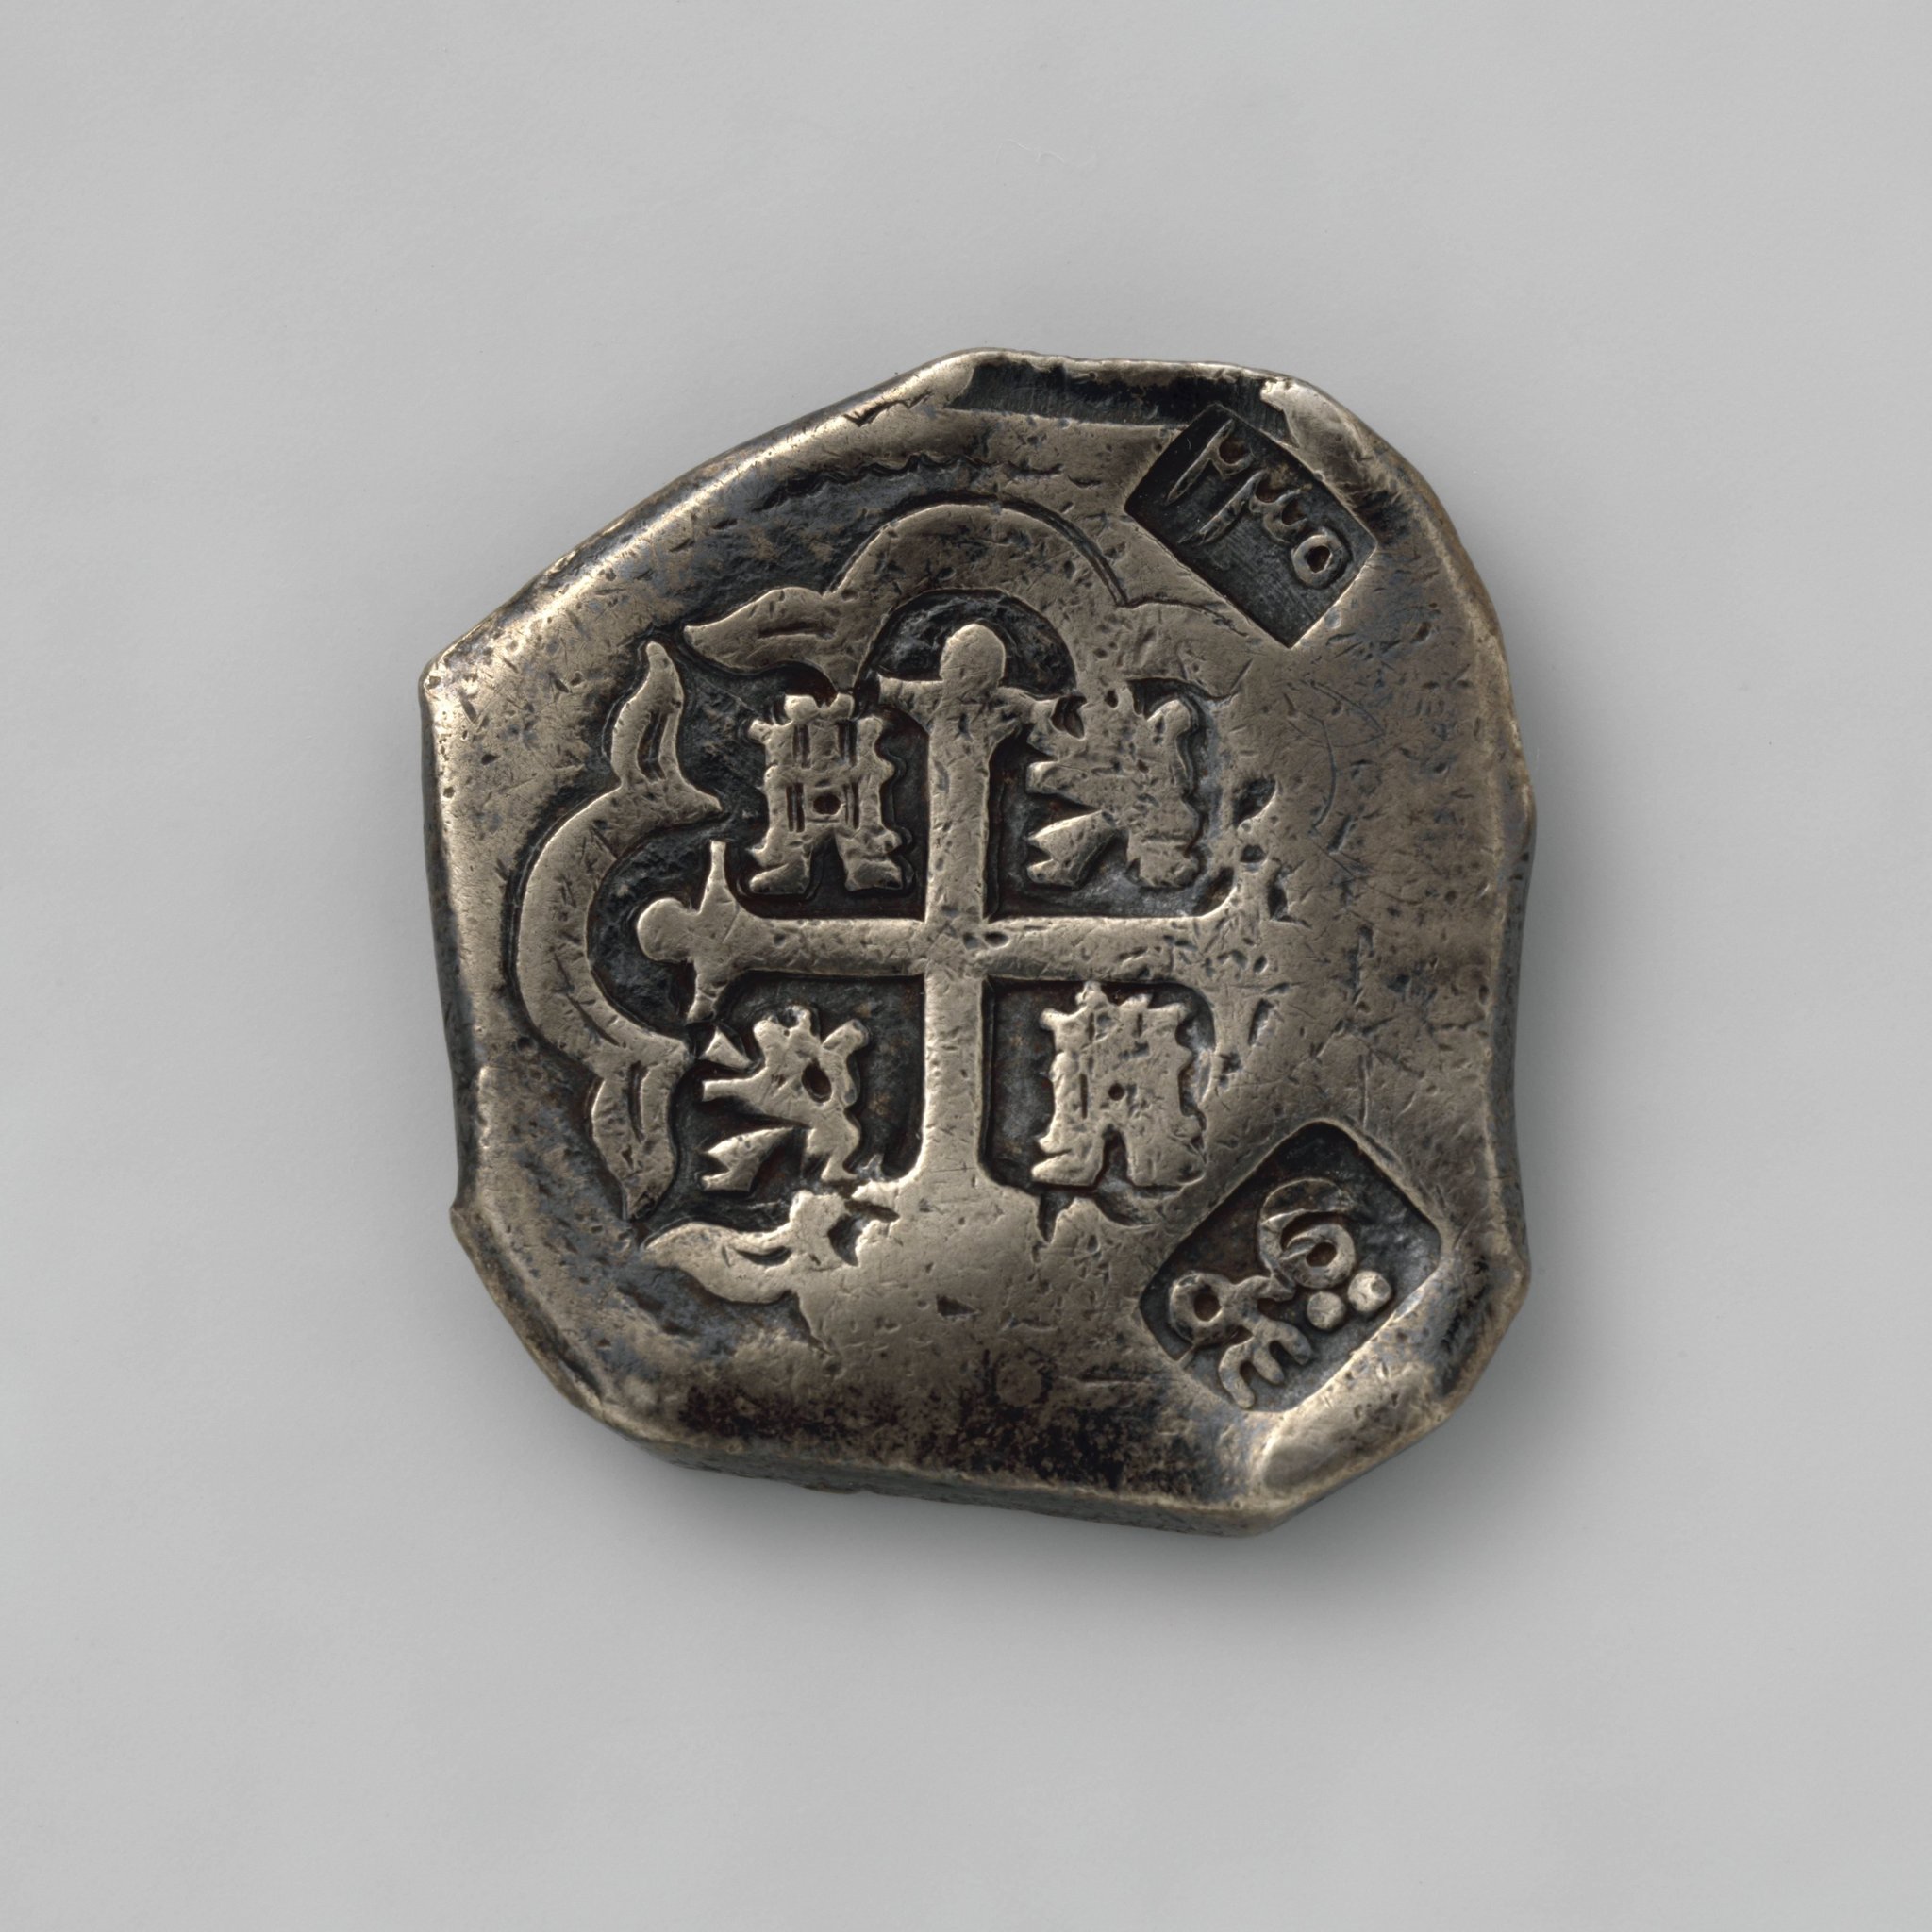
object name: coin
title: Spaanse acht reaal uit Mexico met kloppen Soemenep en 235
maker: Anonymous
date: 1732-1819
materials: silver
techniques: casting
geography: madura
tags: mexico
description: Zilveren munt in ruwe rechthoekige vorm. Voorzijde: gekroond Spaans wapenschild. Jaartal in omschrift. Keerzijde: in een veelpas kruis met in de hoeken wapens van Castilië en Leon. Op uiteinden twee kloppen: Soemenep en 235 [=A.H. 1235=1819]